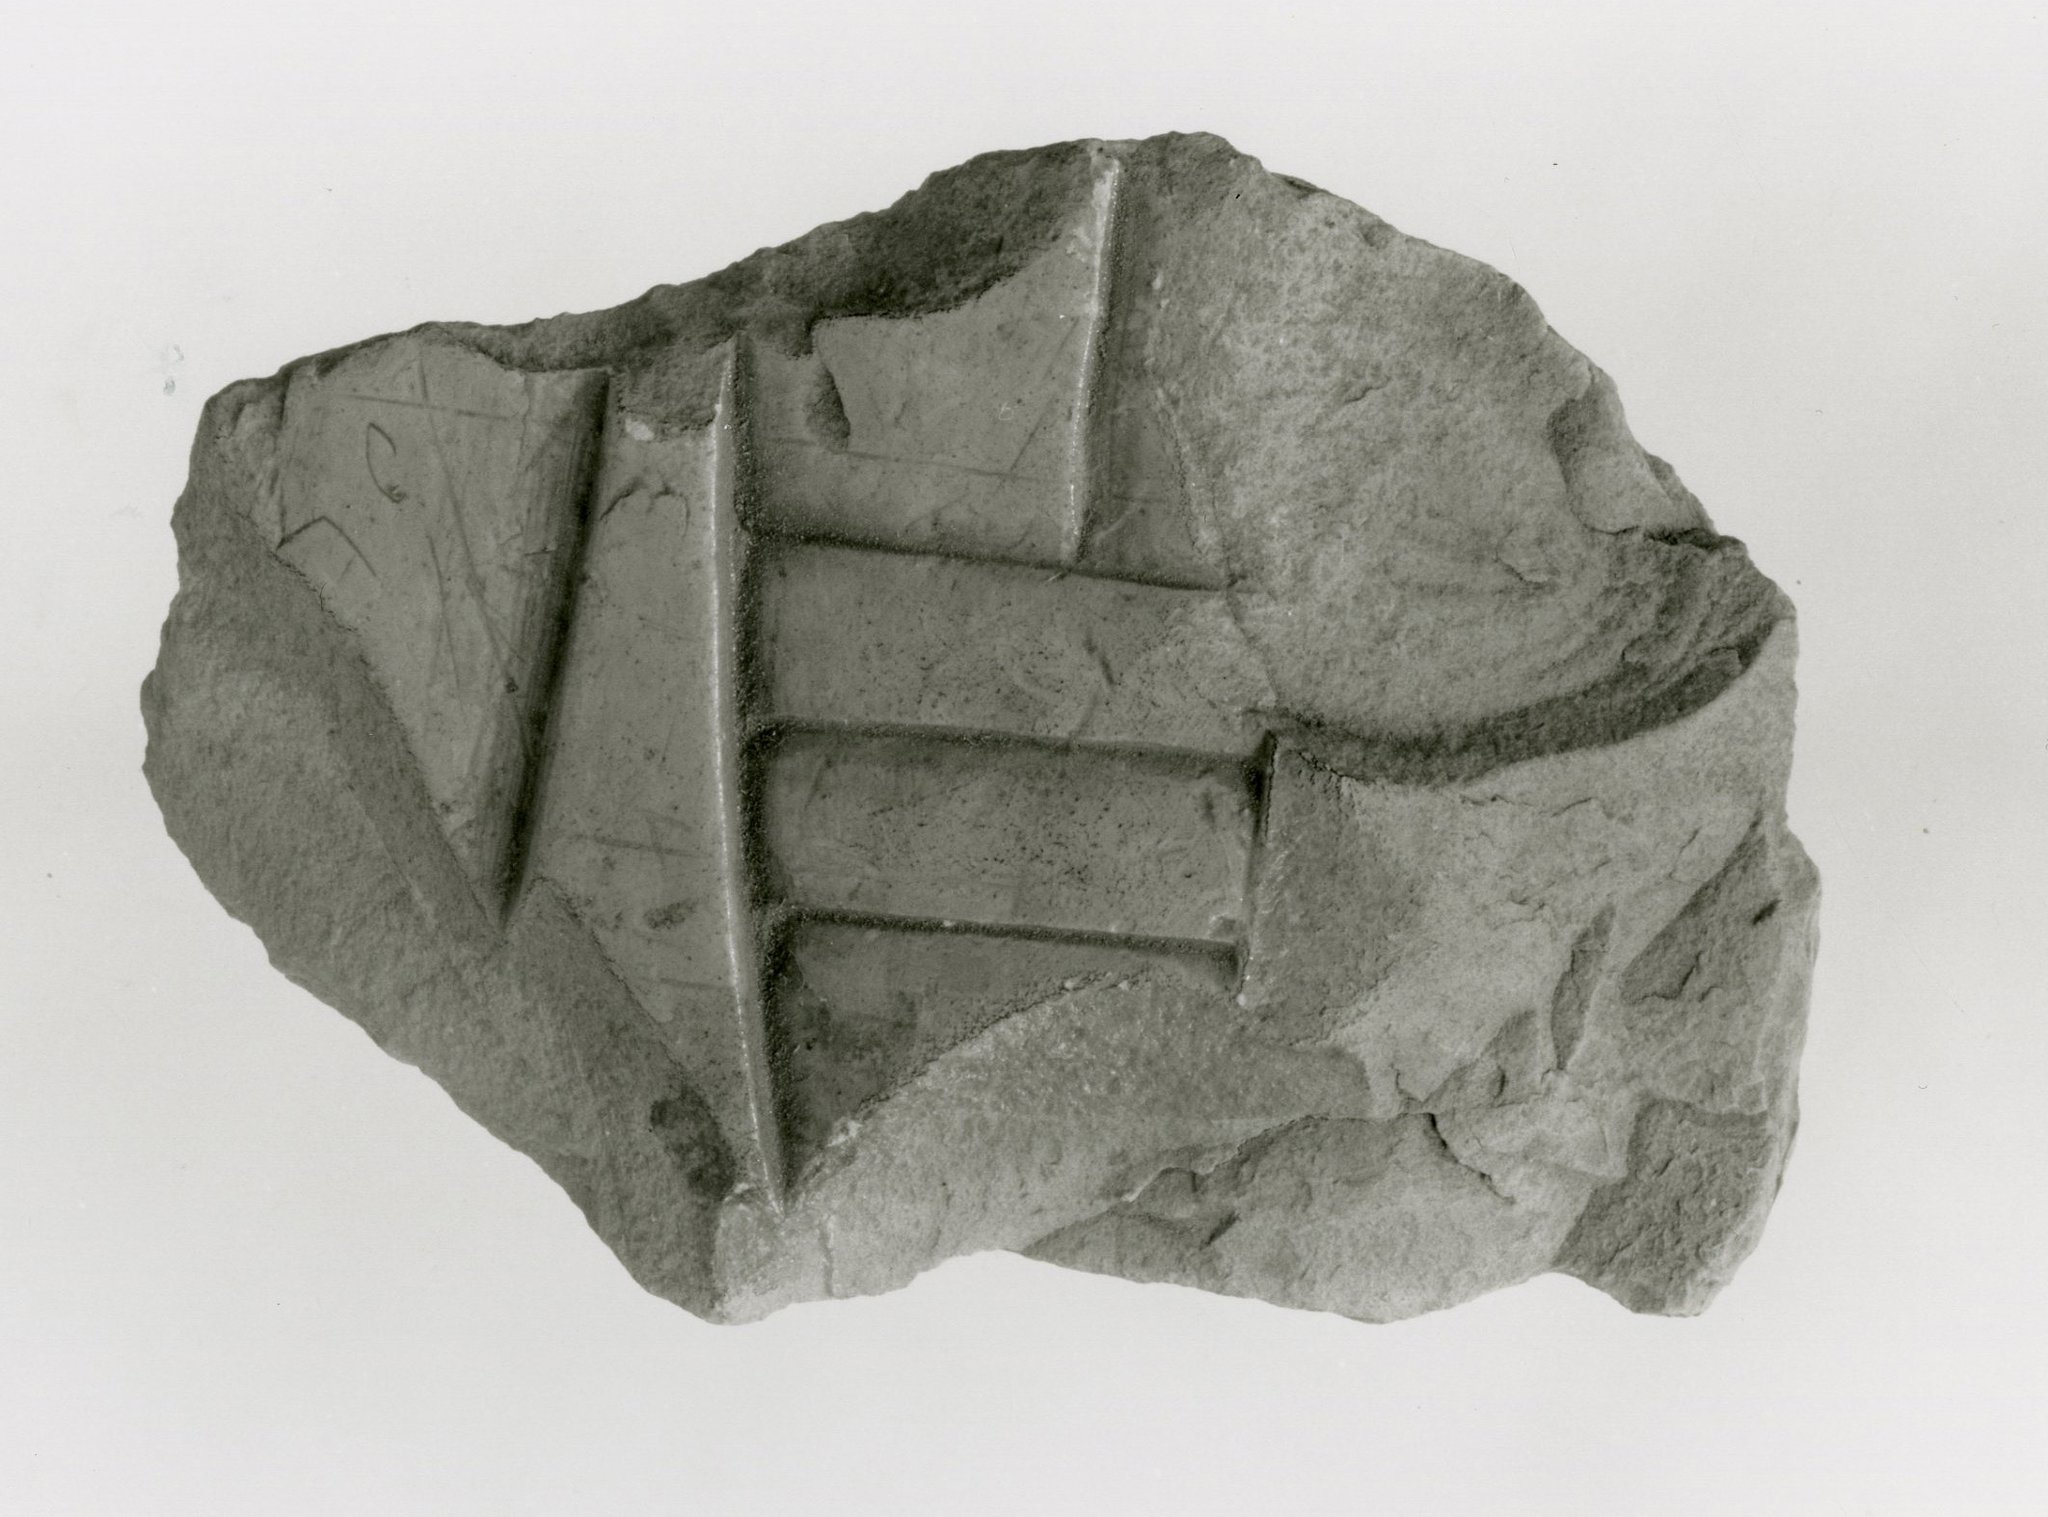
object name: relief, tomb of nespekashuty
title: Raised relief fragment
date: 664-610 BCE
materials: limestone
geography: egypt